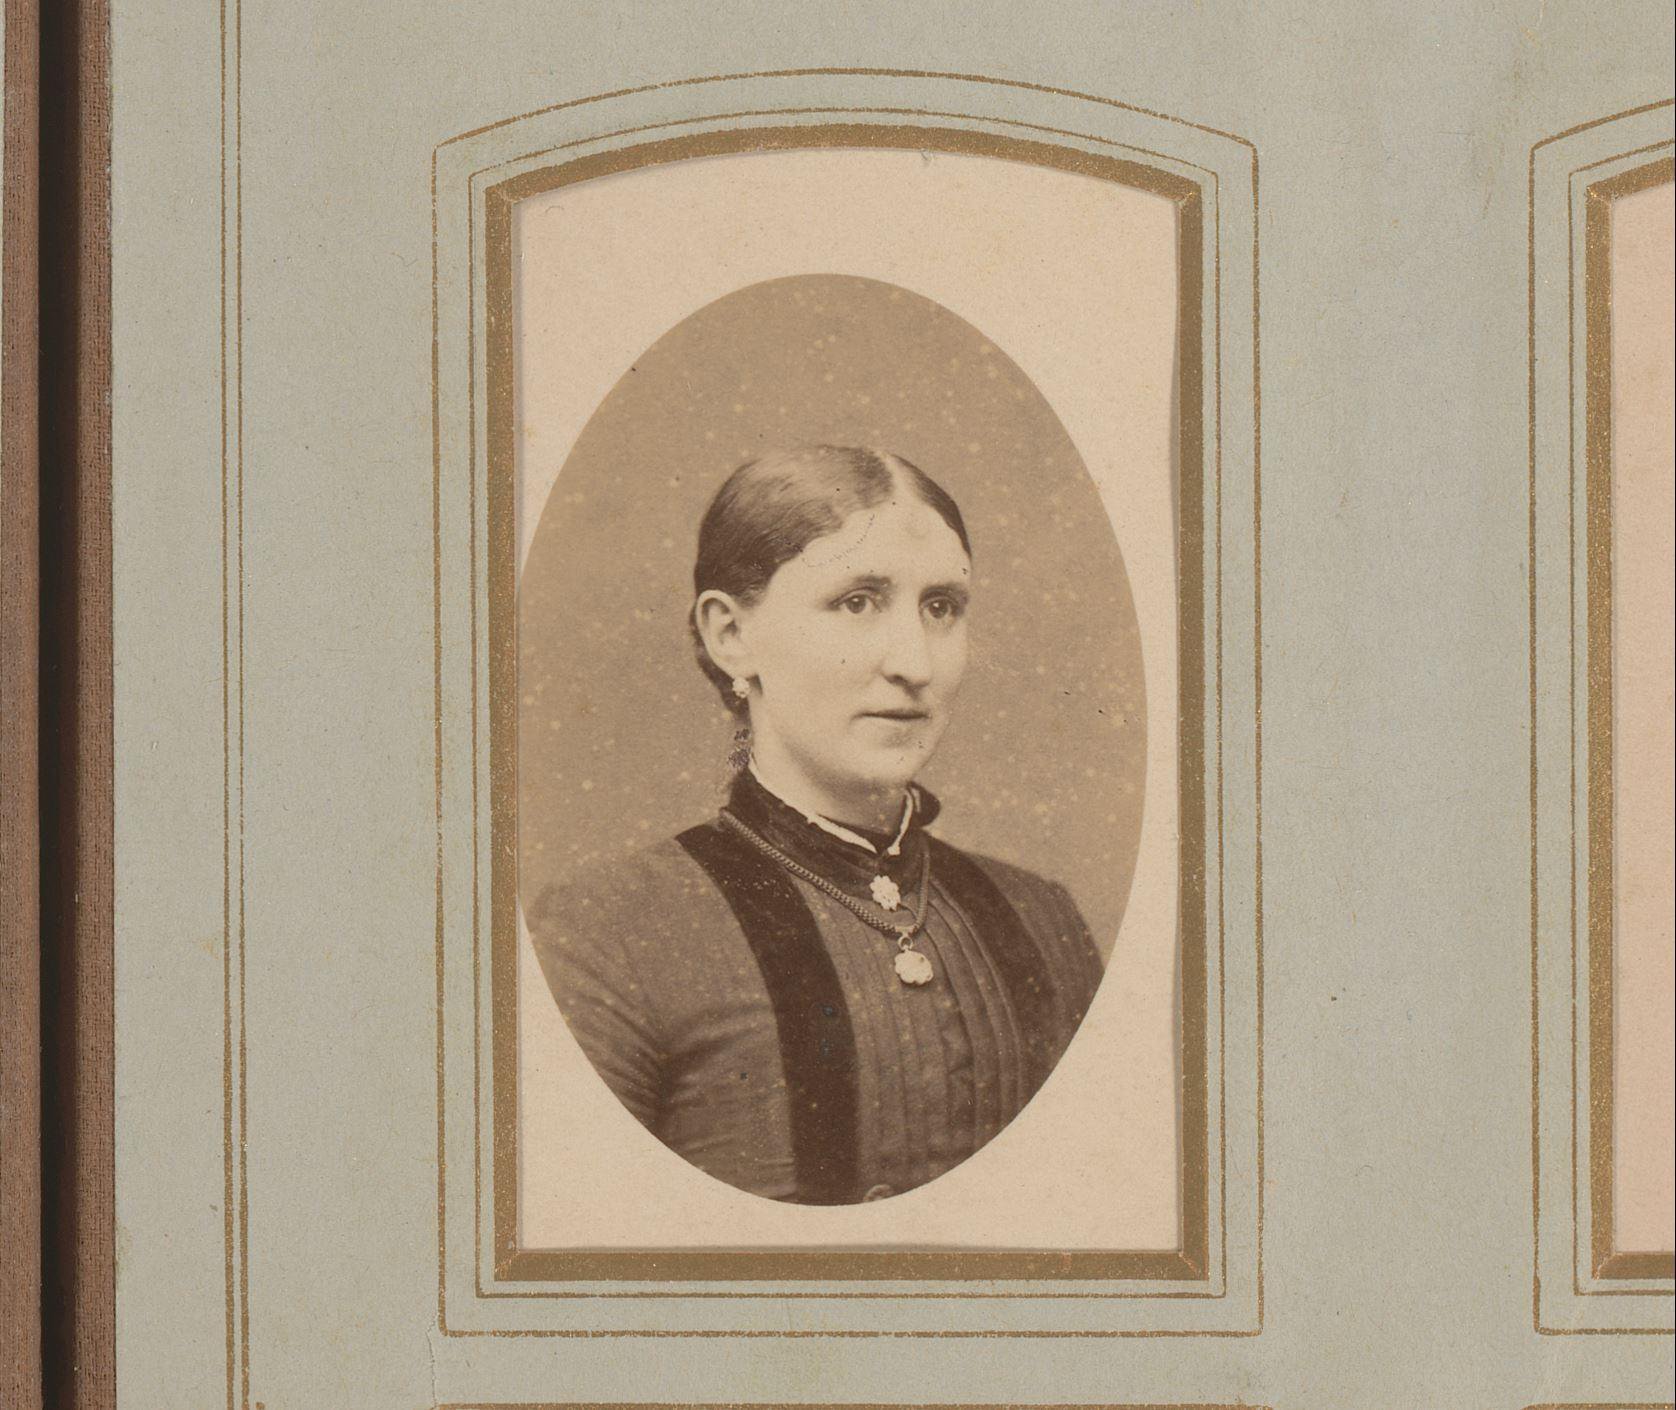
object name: photograph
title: Portret van een vrouw met halsketting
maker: louis robert werner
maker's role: fotograaf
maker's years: 1834-1896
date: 1866-1896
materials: cardboard, photographic support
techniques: albumen print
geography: amsterdam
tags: historical persons - bb - woman, necklace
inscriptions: number: ‘81’, inscription: ‘L. R. Werner/ voorheen P. Carstensen/ Amsterdam/ Nieuwendijk H 150./ Nabestellingen en Vergrotingen,/ ook van anderen Portretten, kunnen iederen tijd/ geleverd worden.’